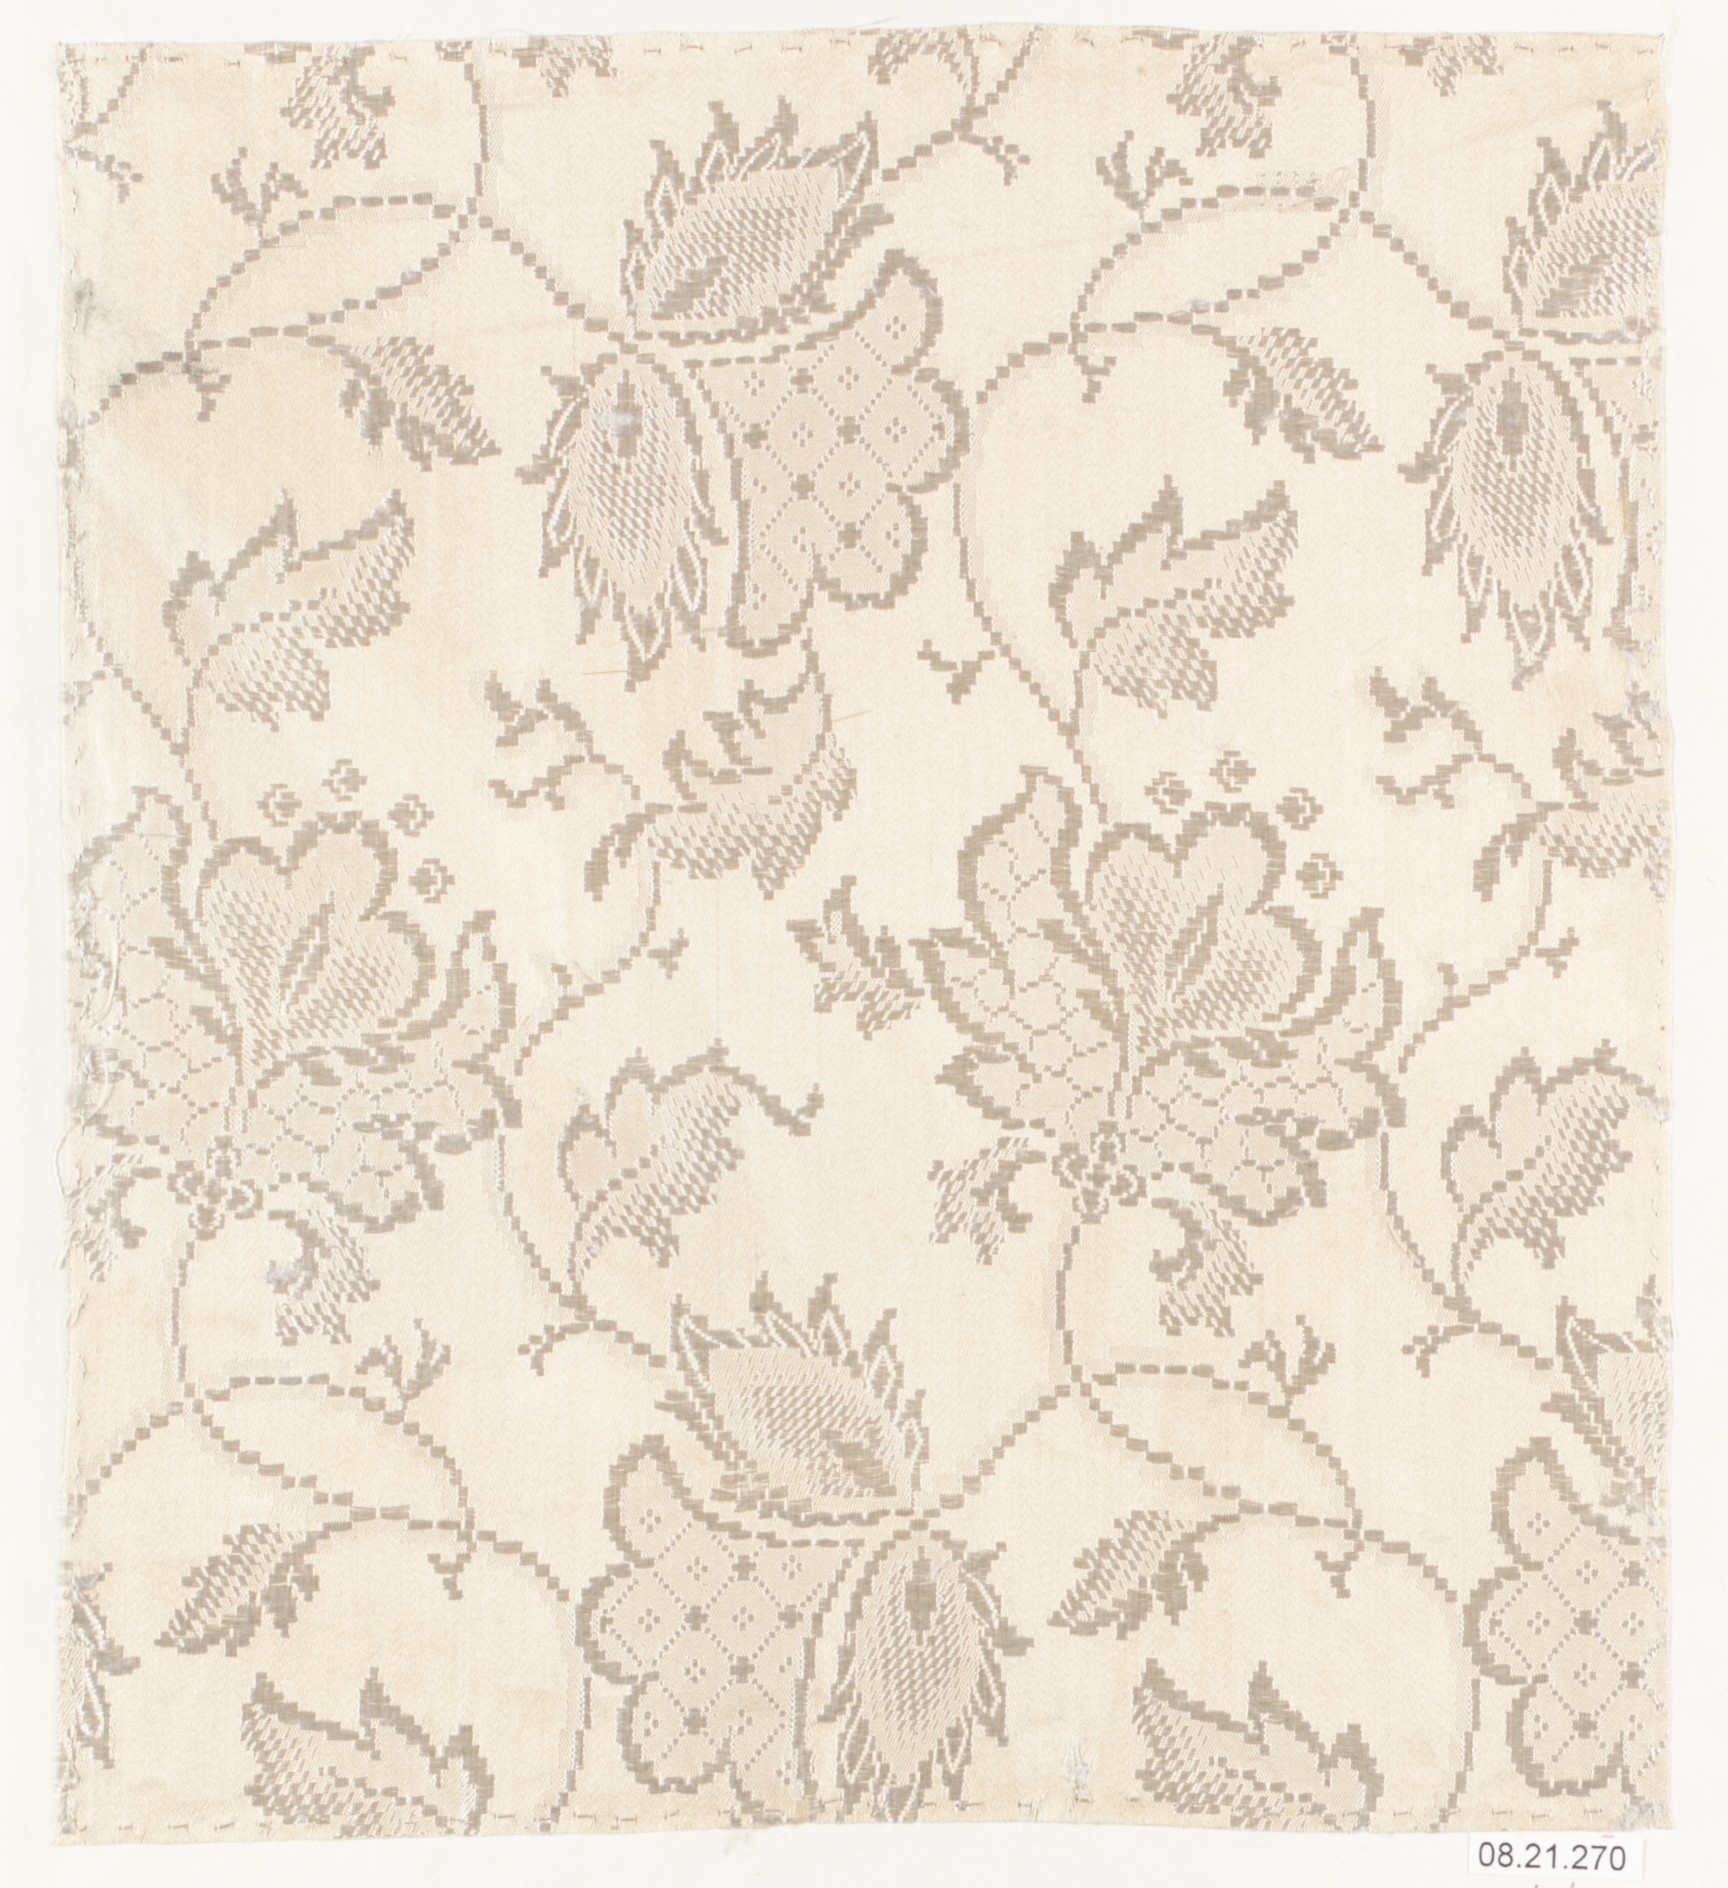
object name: textile sample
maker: Anonymous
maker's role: designer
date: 1900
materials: silk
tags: flowers